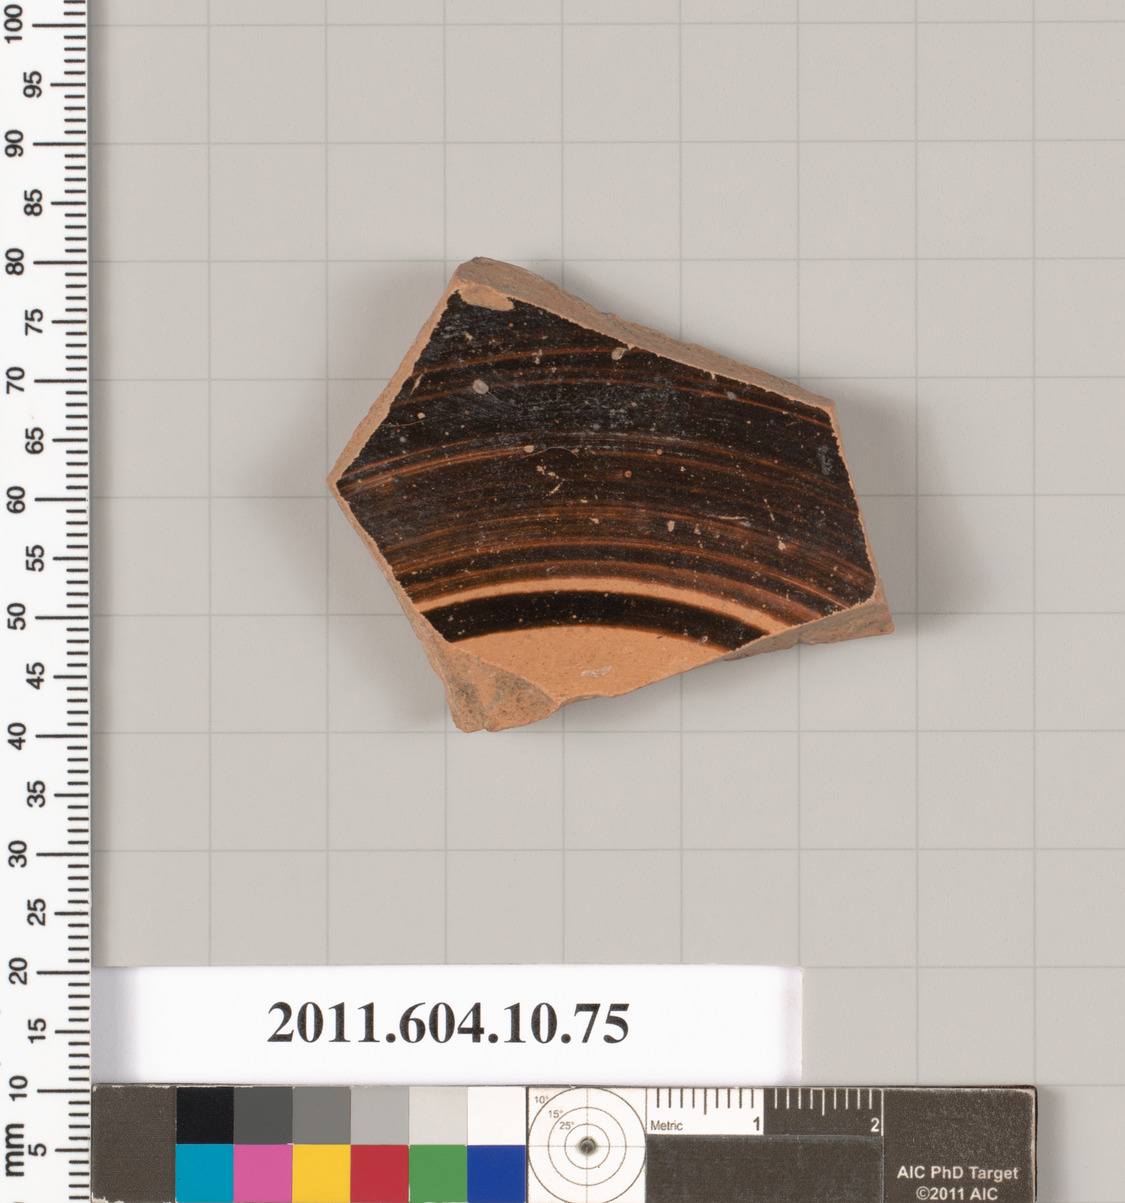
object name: fragment of a bowl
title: Terracotta fragment of a bowl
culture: etruscan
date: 400-301 BCE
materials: terracotta